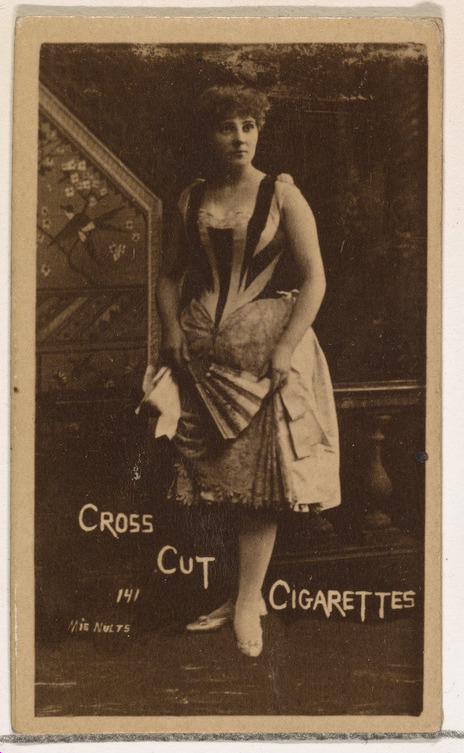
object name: print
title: Card Number 141, Miss Nults, from the Actors and Actresses series (N145-1) issued by Duke Sons & Co. to promote Cross Cut Cigarettes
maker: w. duke, sons & co.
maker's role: publisher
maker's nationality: american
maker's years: 1870-1920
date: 1880-1889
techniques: albumen silver print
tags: portraits,women,actresses